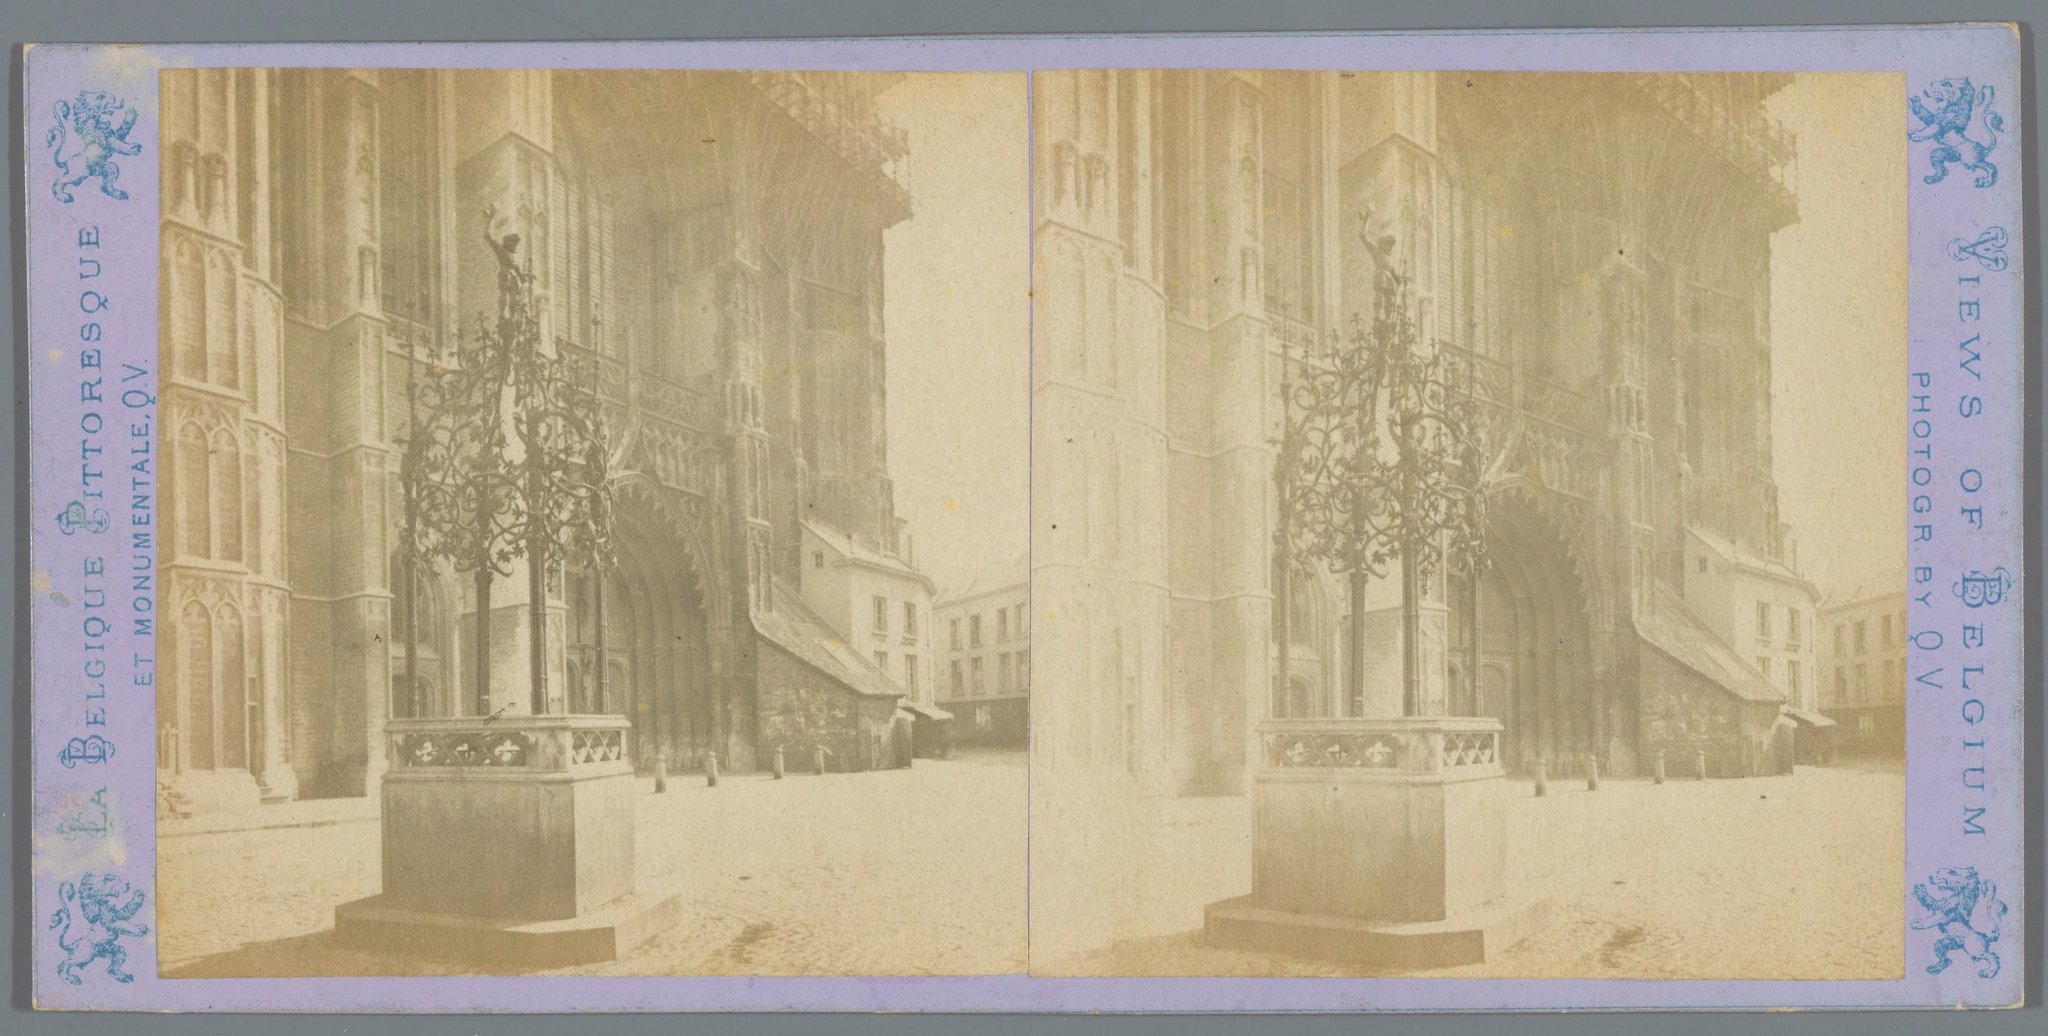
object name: stereograph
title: La Belgique pittoresque et monumentale / Views of Belgium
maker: jules hippolyte quéval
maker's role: publisher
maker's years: 1824-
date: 1866-1870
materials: cardboard, paper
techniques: albumen print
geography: antwerp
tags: well, square, place, circus, etc., antwerp